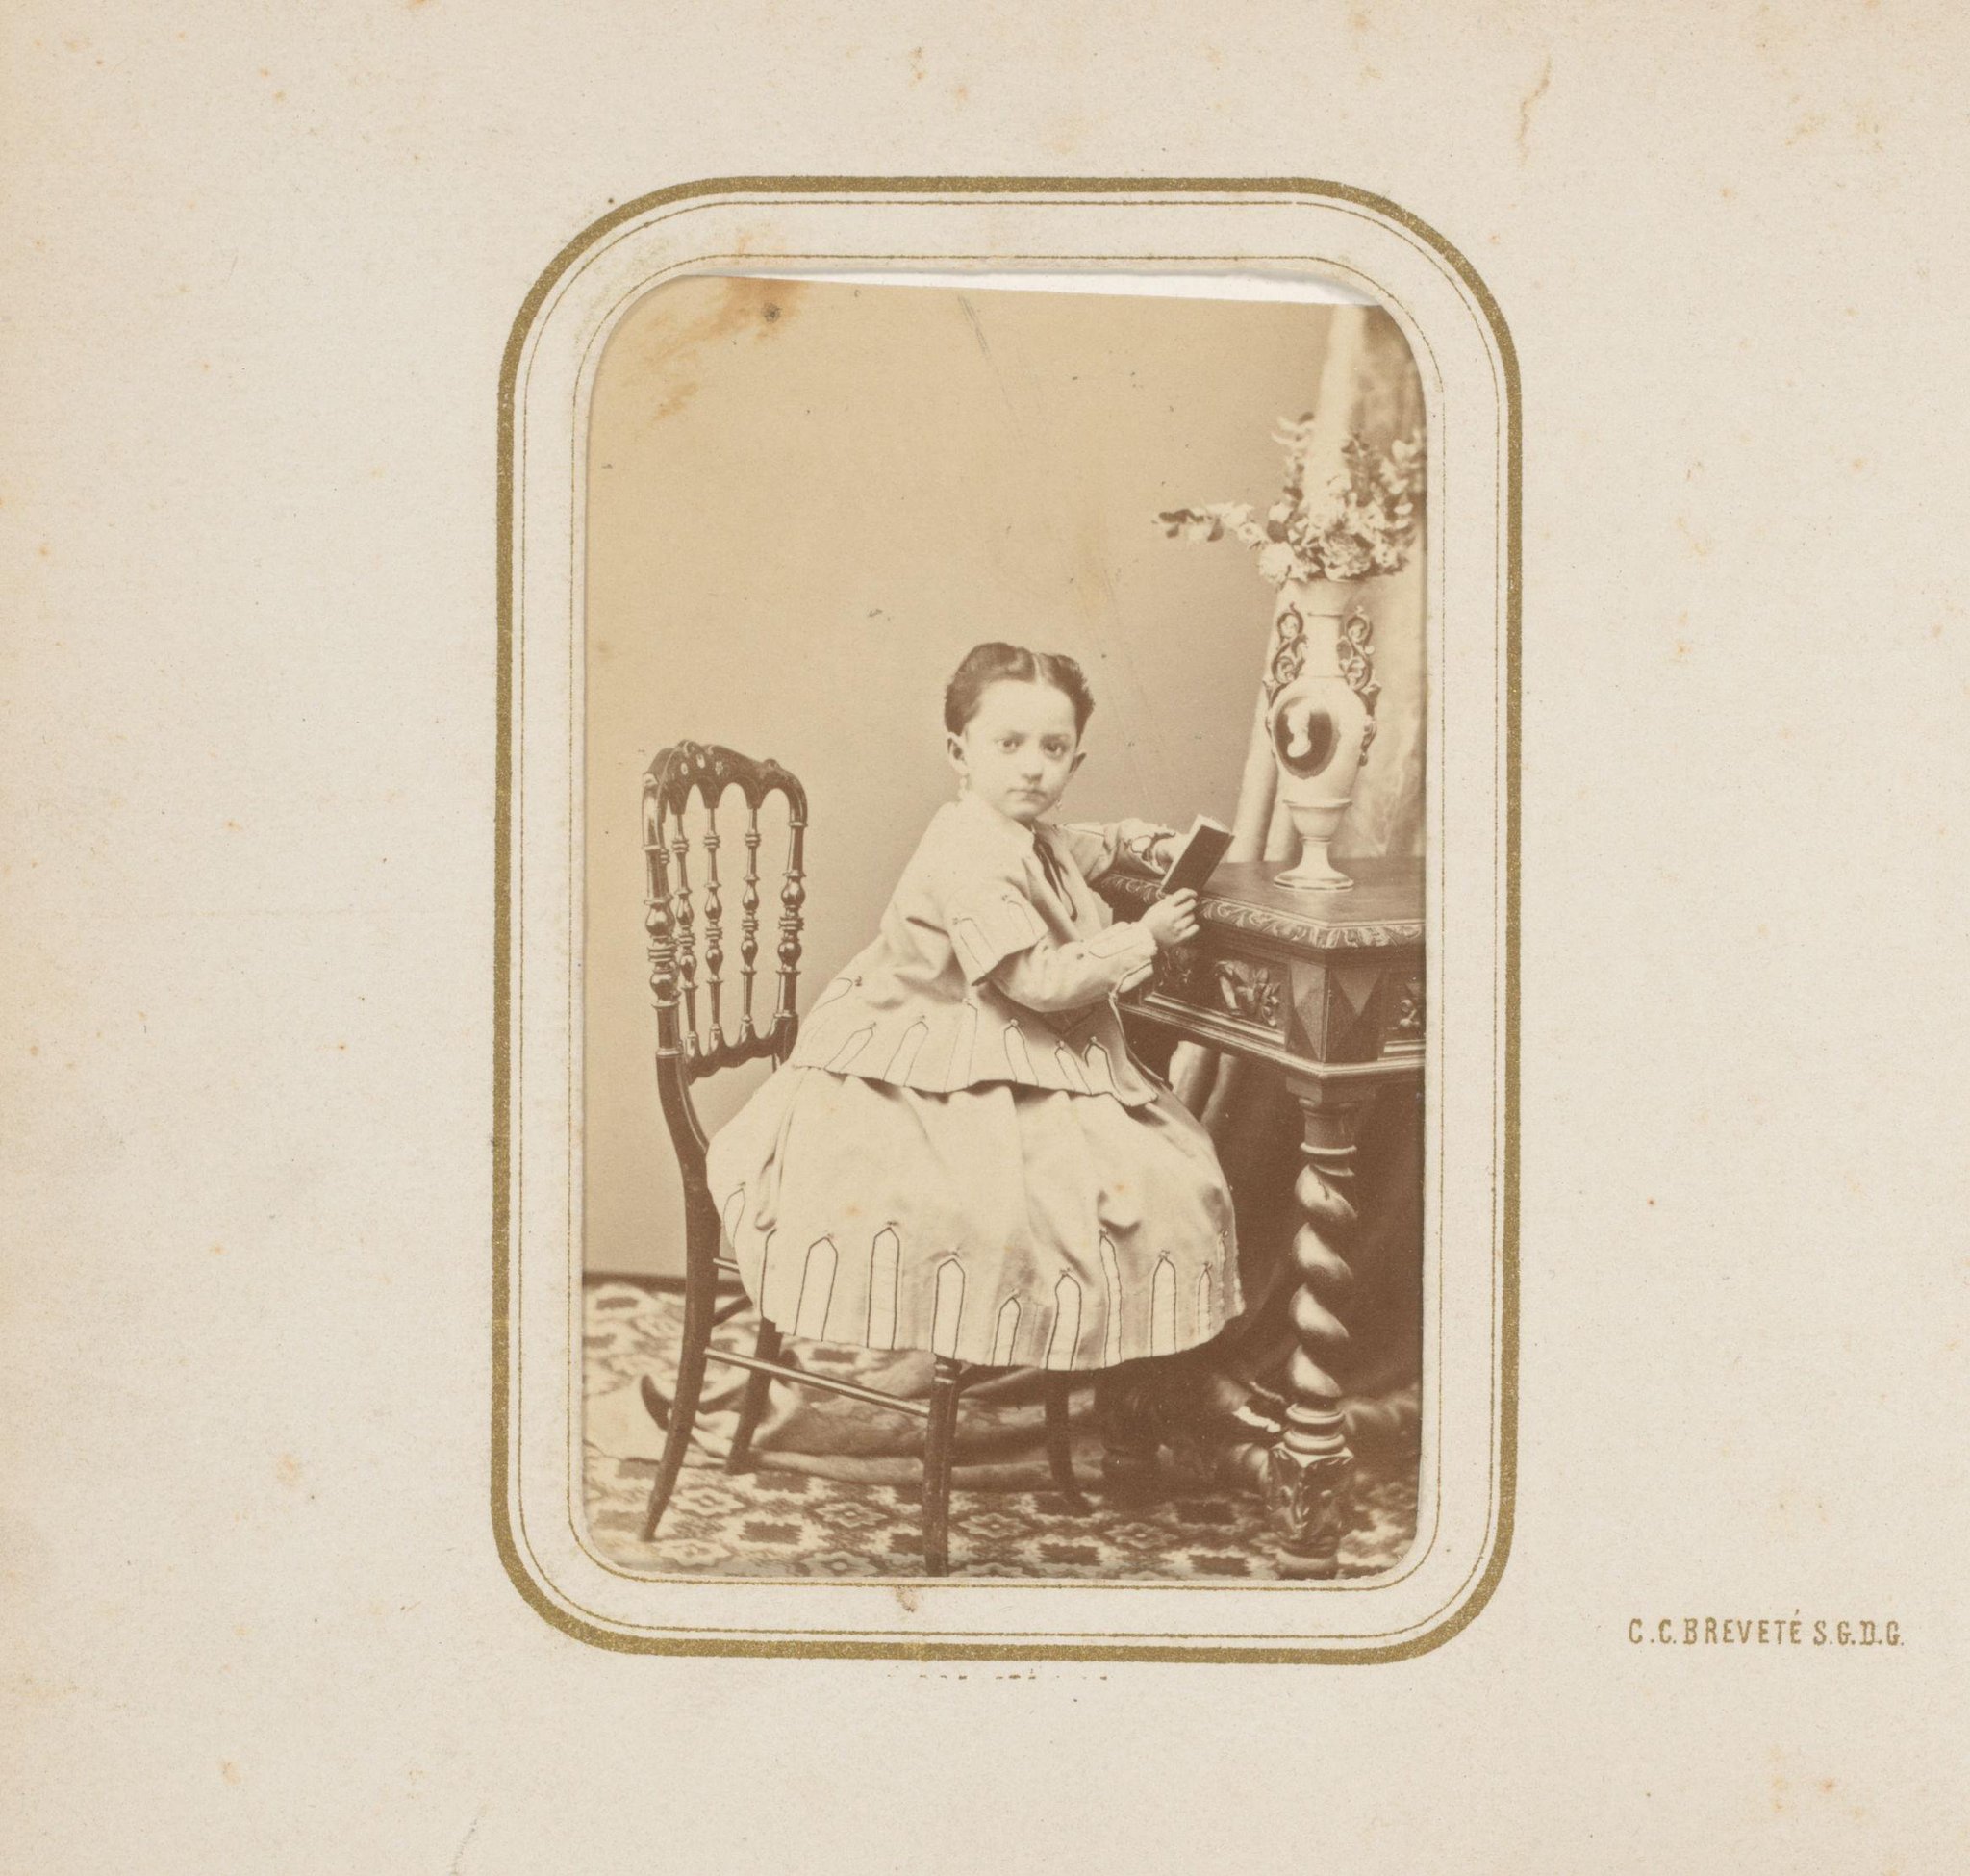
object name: album leaf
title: Portret van een meisje, zittend aan een tafel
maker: josé garcía ayola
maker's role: fotograaf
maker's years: 1836-1900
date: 1860-1900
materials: cardboard, photographic support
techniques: albumen print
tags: sitting figure, historical persons, girl (child between toddler and youth)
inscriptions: inscription: ‘J. Garcia Ayola/ Fotografo/ Calle de Recojidas, 33/ Granada’